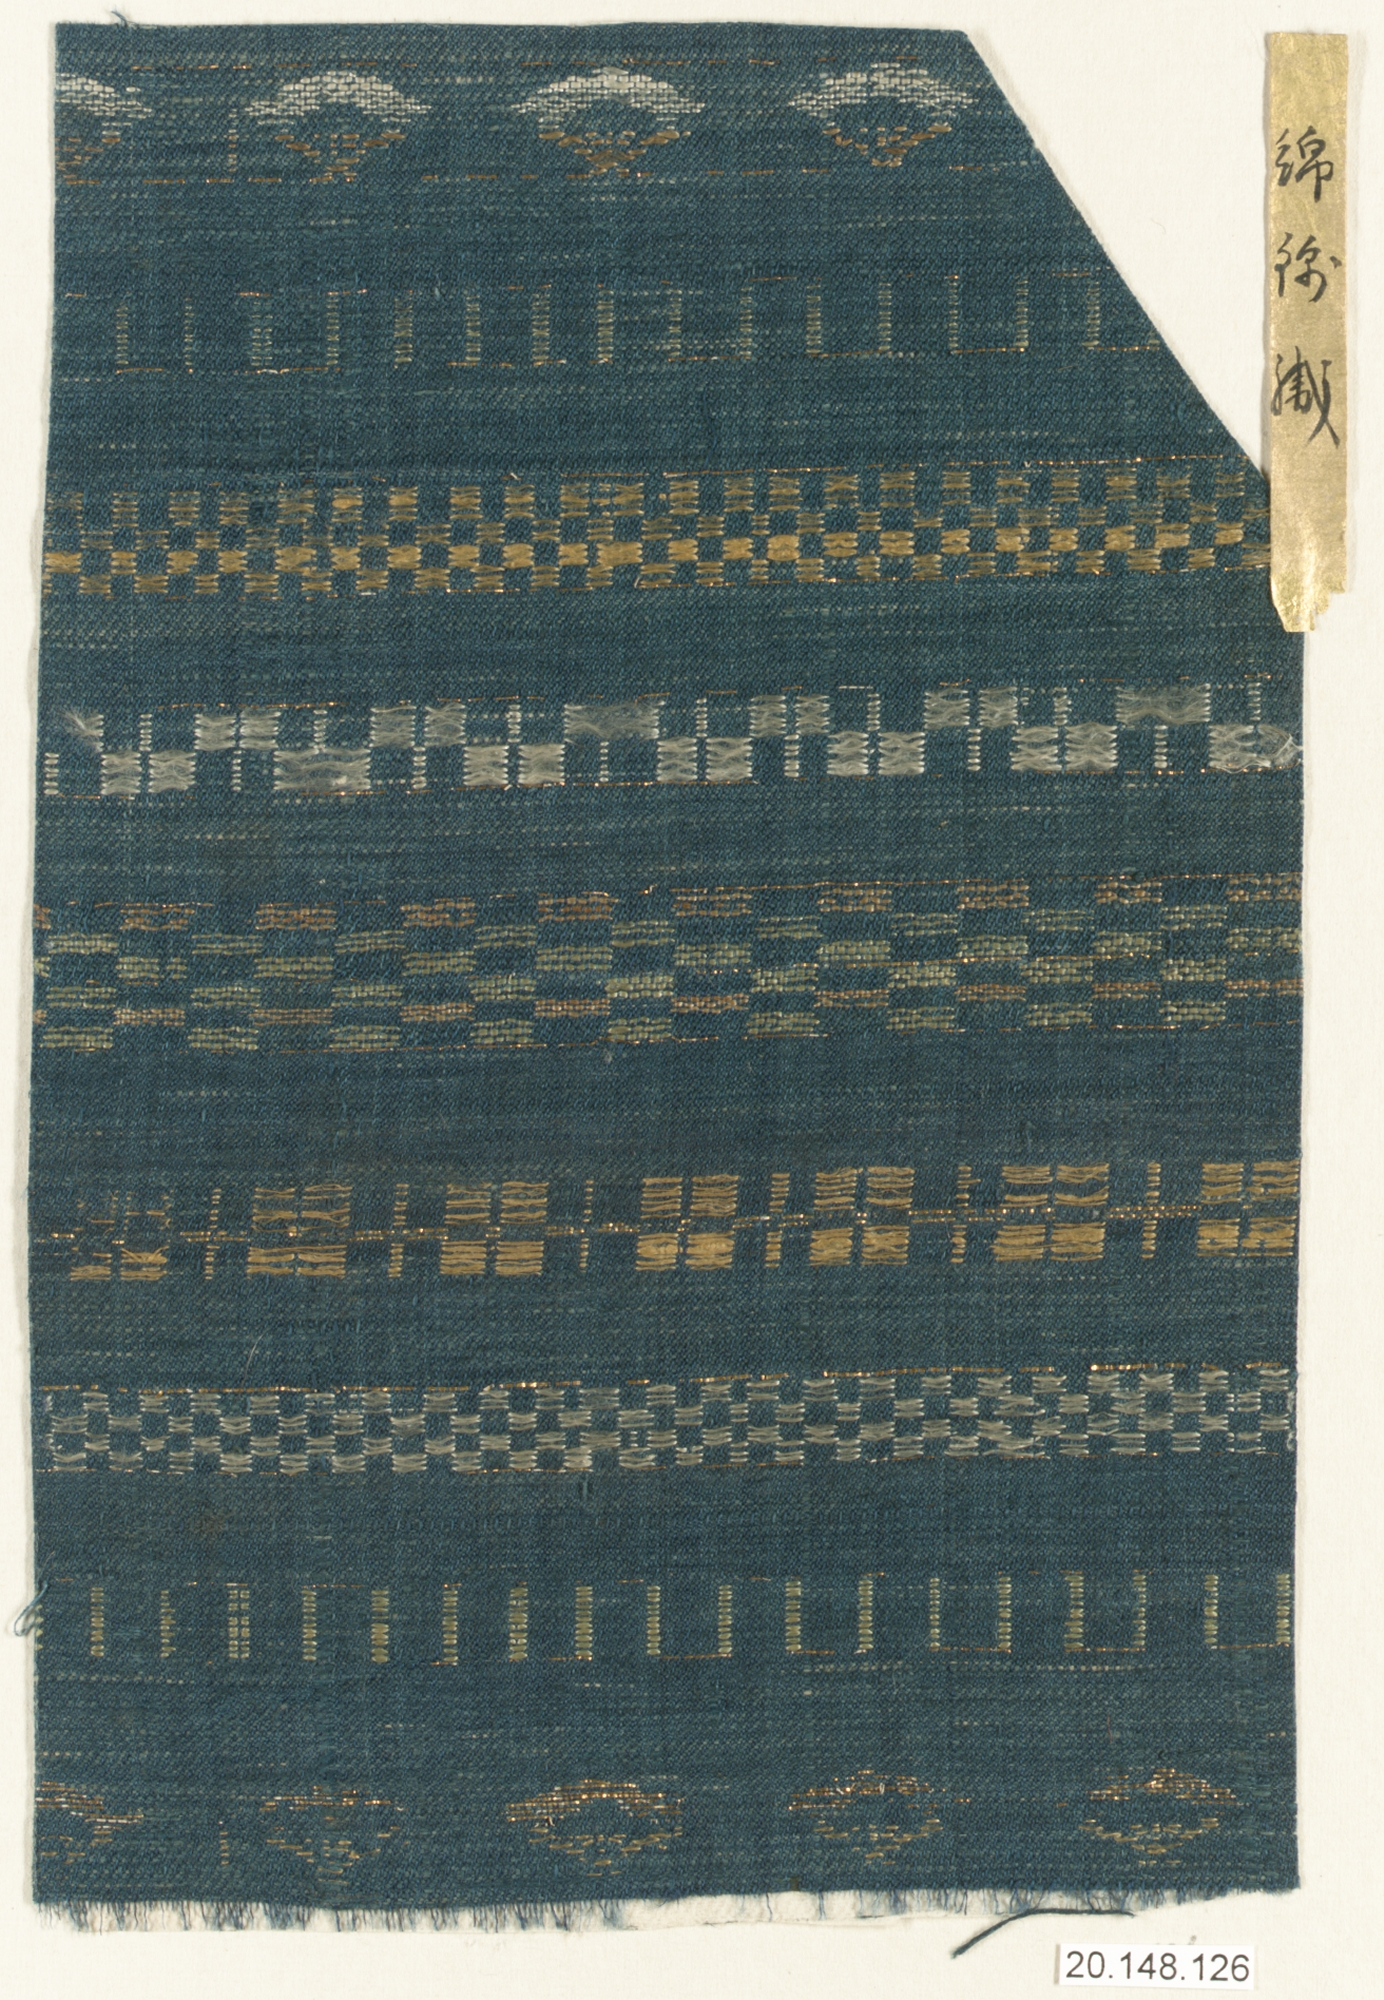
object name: piece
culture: japanese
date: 1601-1700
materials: silk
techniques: compound weave